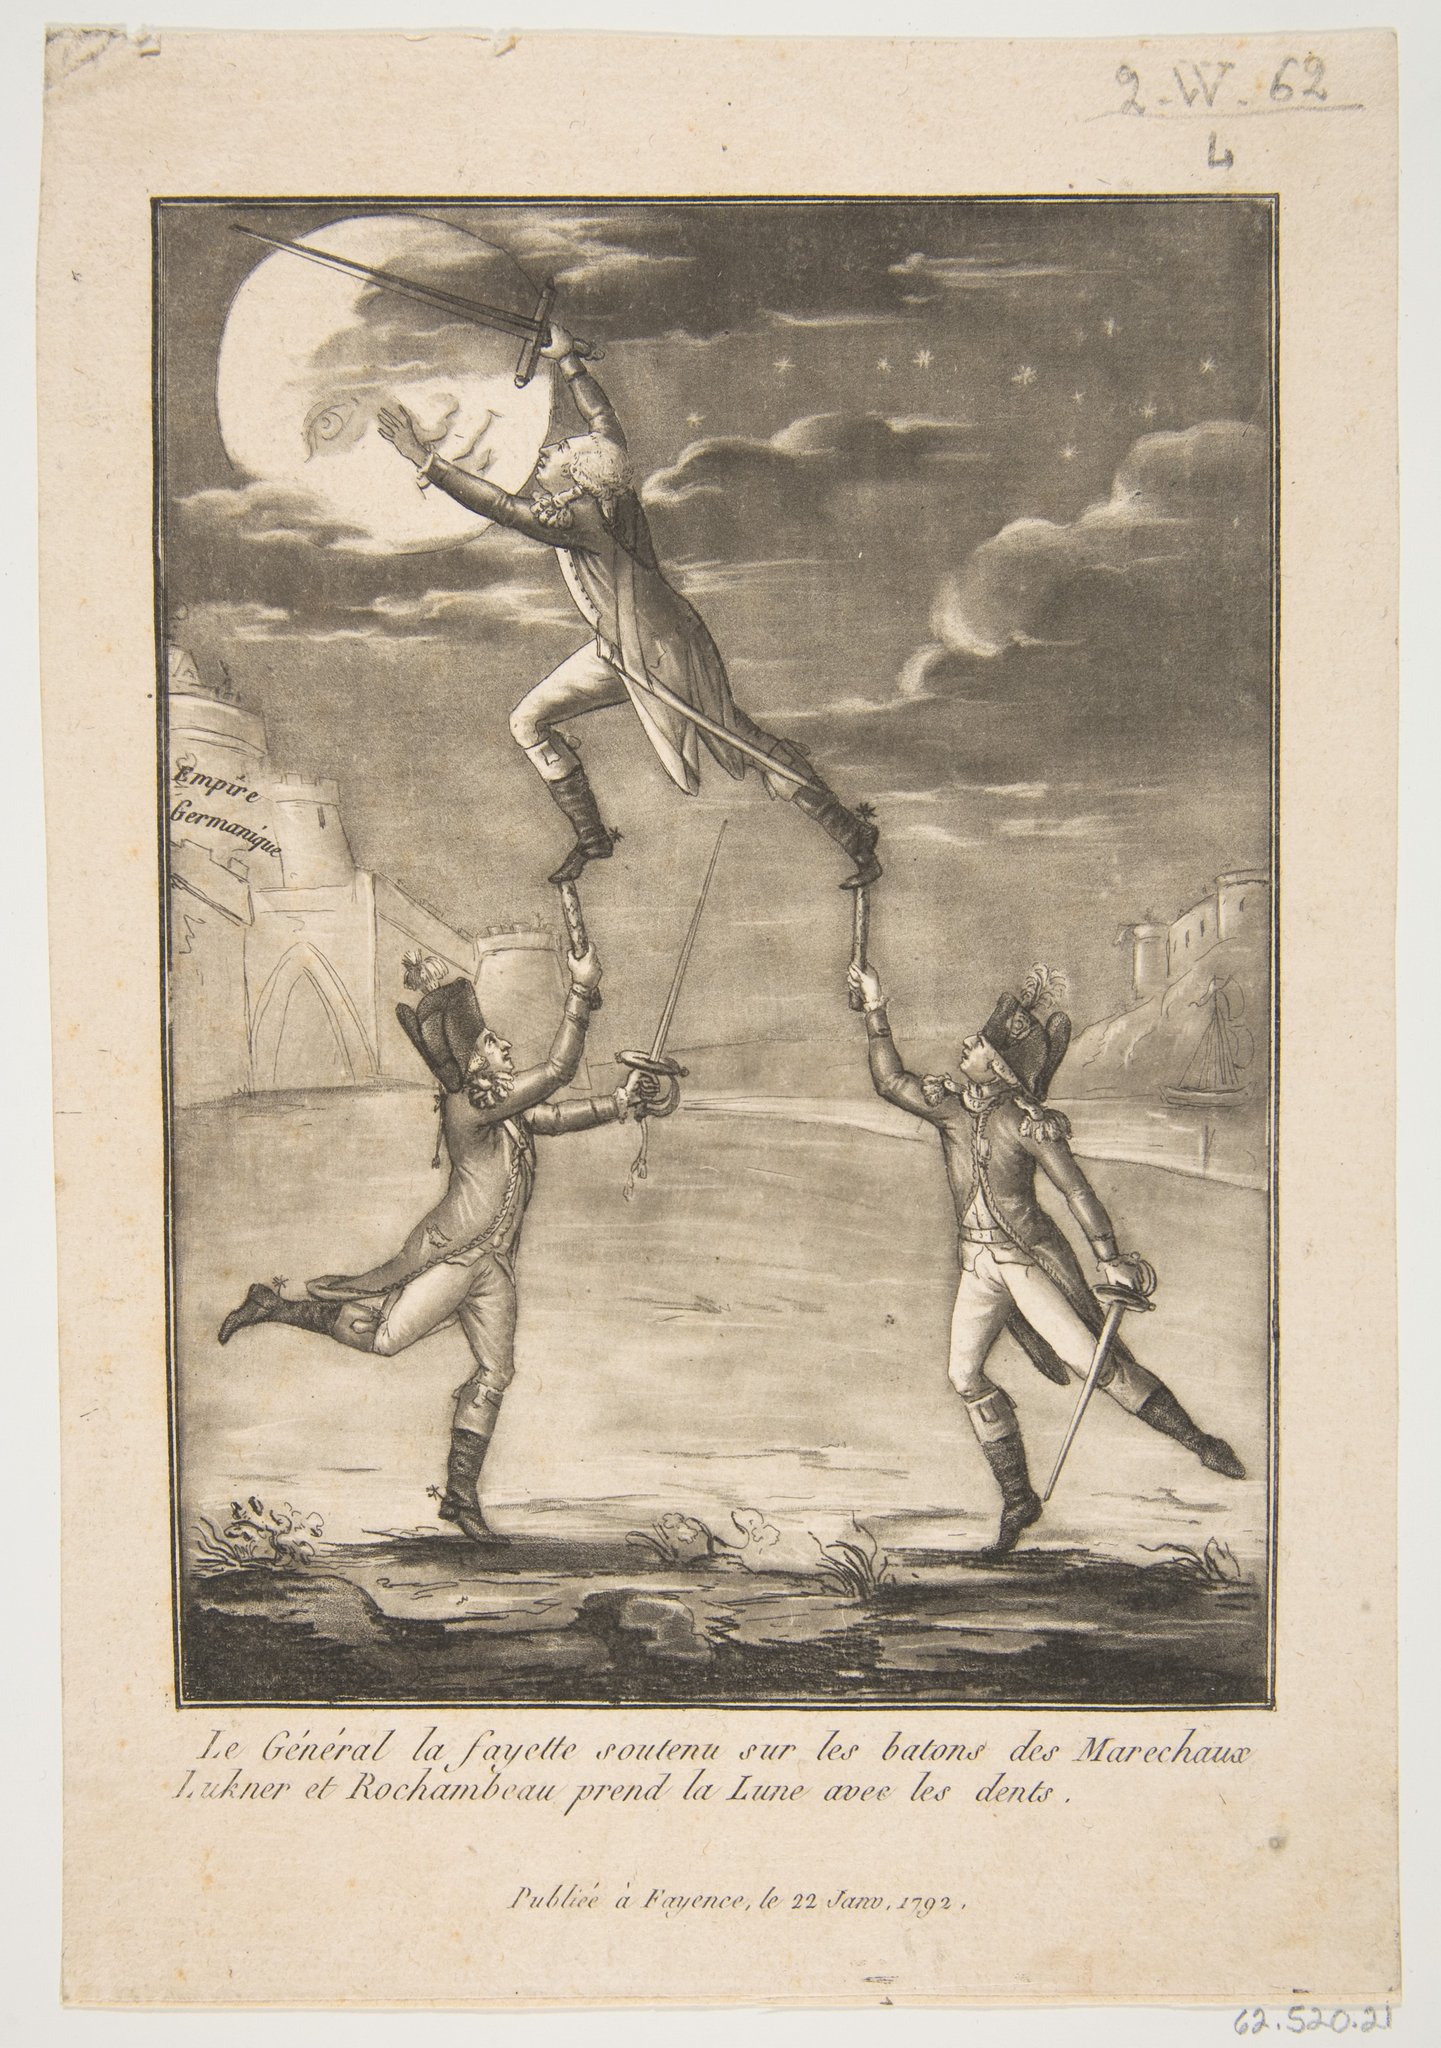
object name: print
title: Le Général la fayette soutenu sur les batons des marechaux Lukner et Rochambeau prend la Lune avec les dents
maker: anonymous, french, 18th century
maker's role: artist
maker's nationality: french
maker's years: 1700-1800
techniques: aquatint, etching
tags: satire,french revolution,men,generals,politics